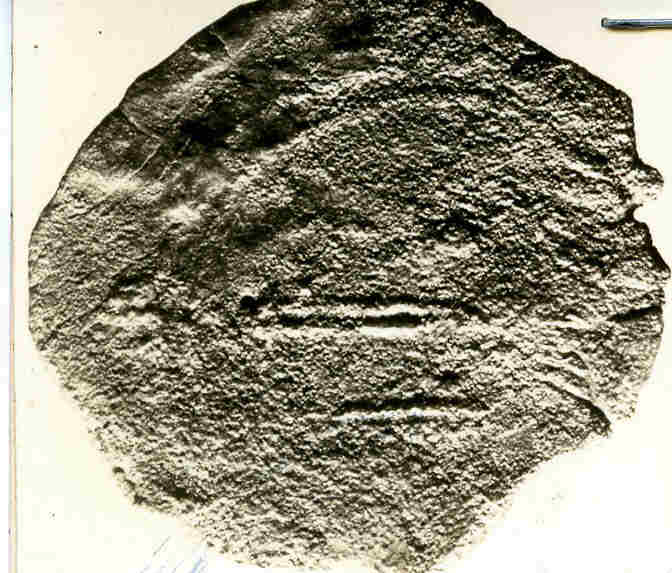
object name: coin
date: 797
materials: copper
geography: iran